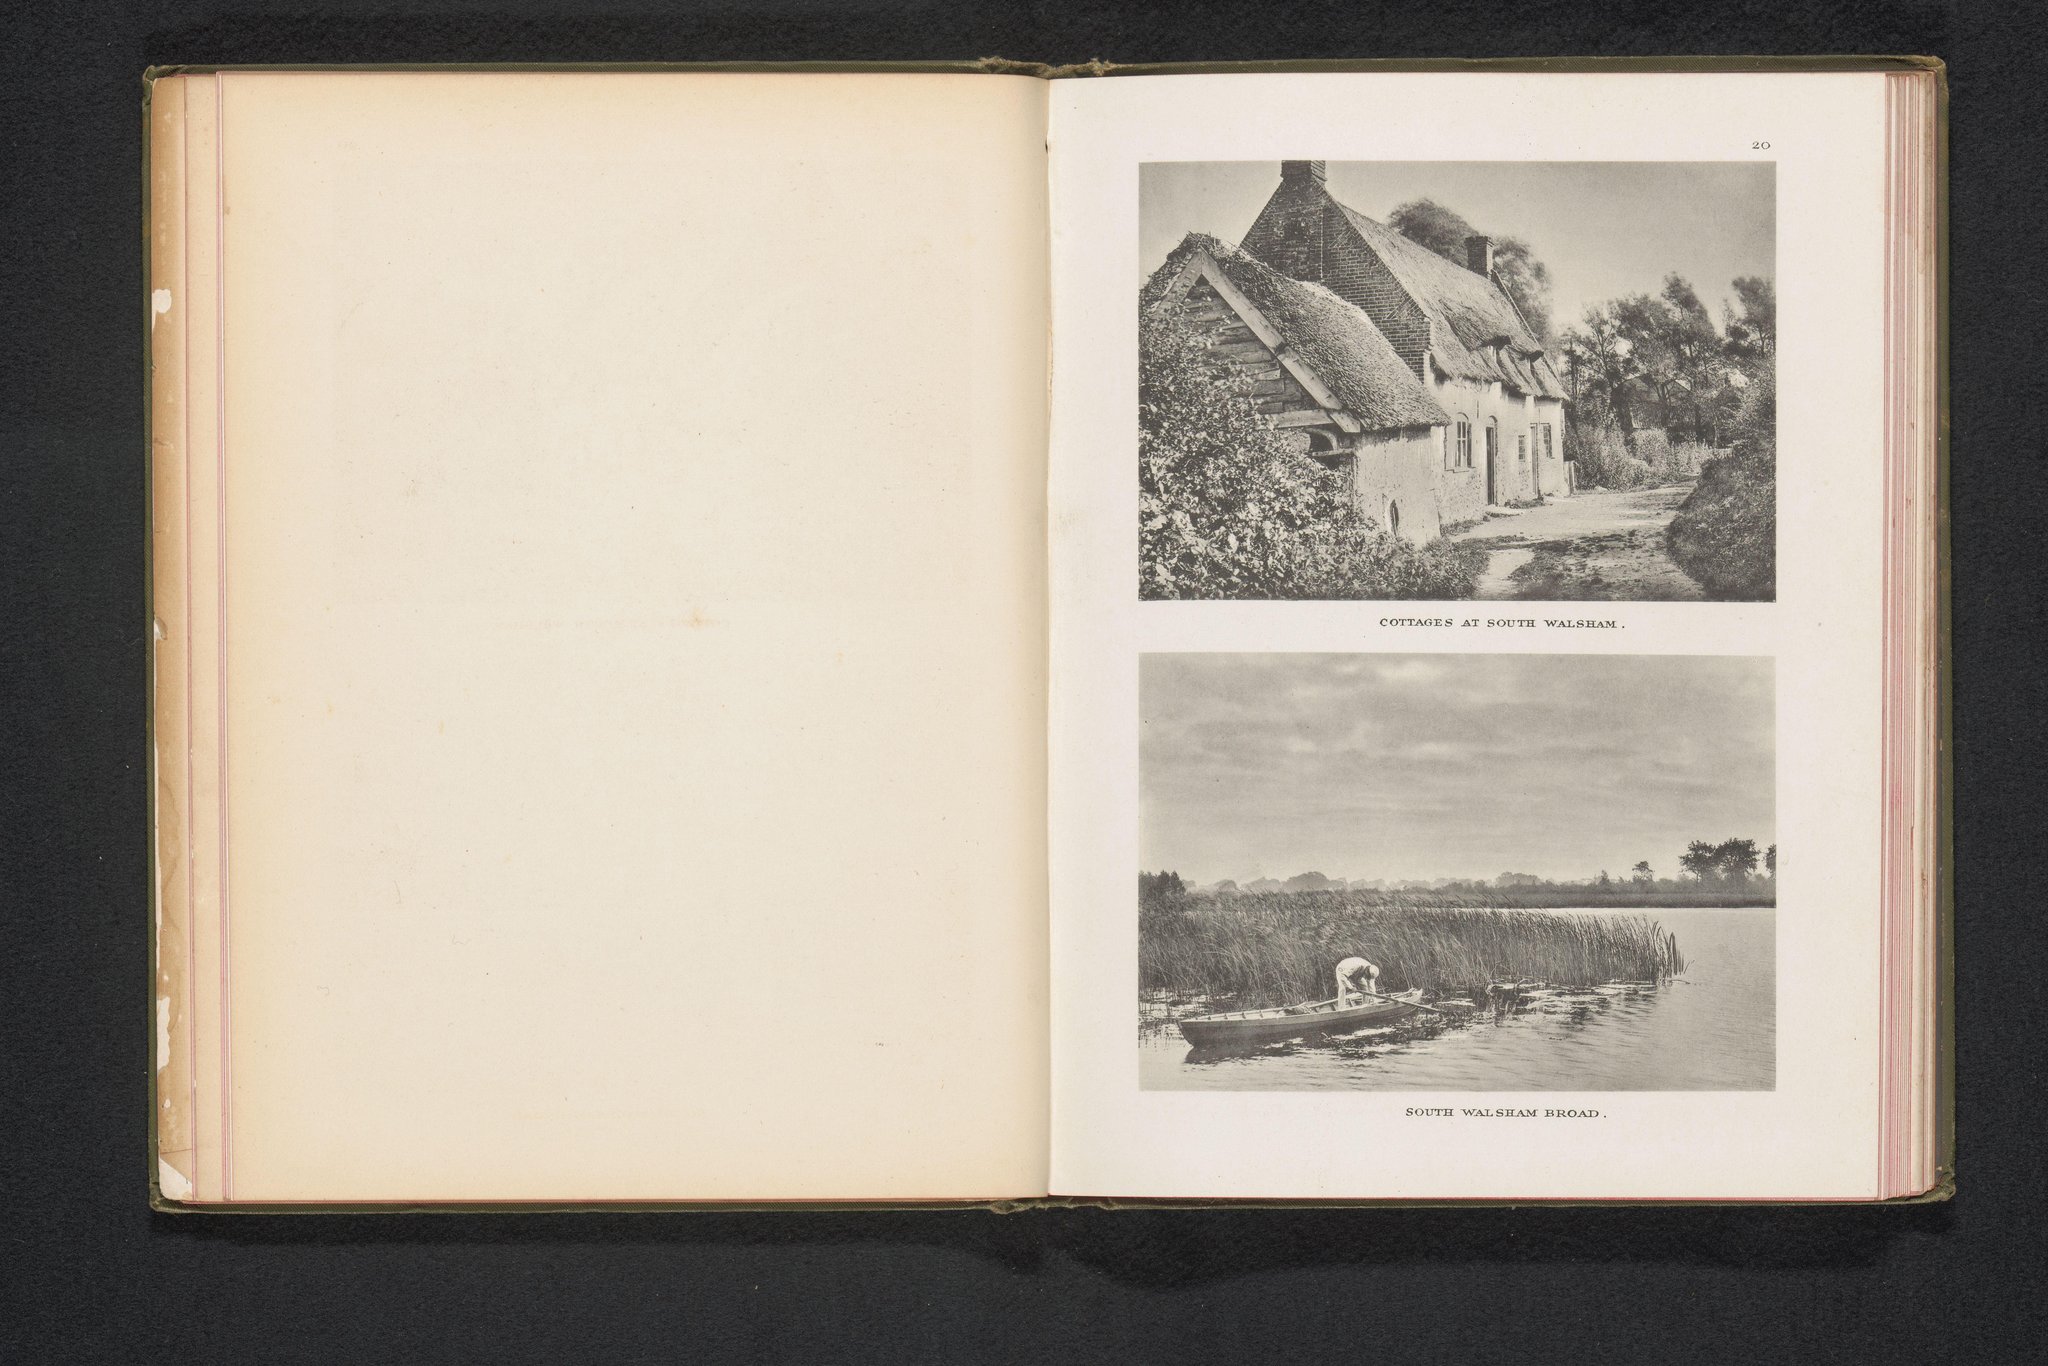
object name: photomechanical print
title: South Walsham Broad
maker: john payne jennings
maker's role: fotograaf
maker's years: 1843-1926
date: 1886-1891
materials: paper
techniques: photograph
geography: south walsham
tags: rowing-boat, canoe, etc., lake